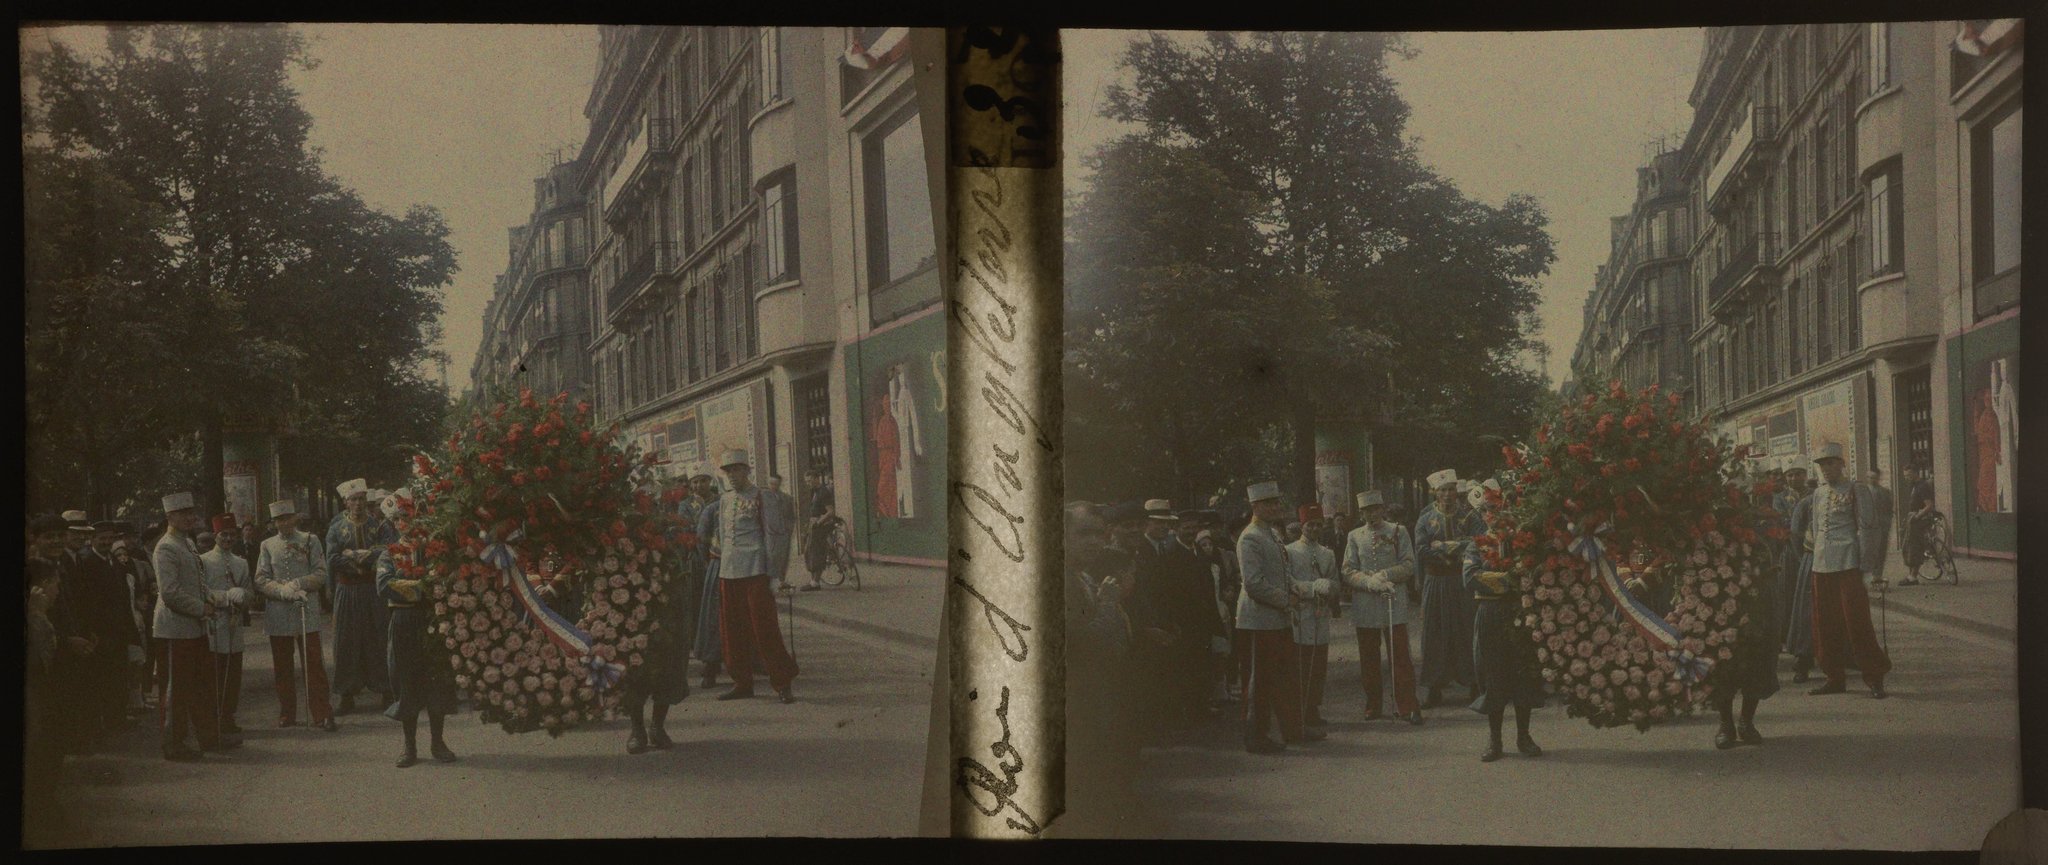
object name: stereograph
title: Franse militairen met een krans, ter gelegenheid van het bezoek van de Engelse koning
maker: Anonymous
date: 1907-1935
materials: paper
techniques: autochrome process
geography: france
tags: public festivities at other royal events, not meant or mentioned above, garland, wreath, military celebrations, france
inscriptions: inscription: ‘Roi d'Angleterre 33’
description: Franse militairen met een krans, ter gelegenheid van het bezoek van de Engelse koning (Edward VII of George V).